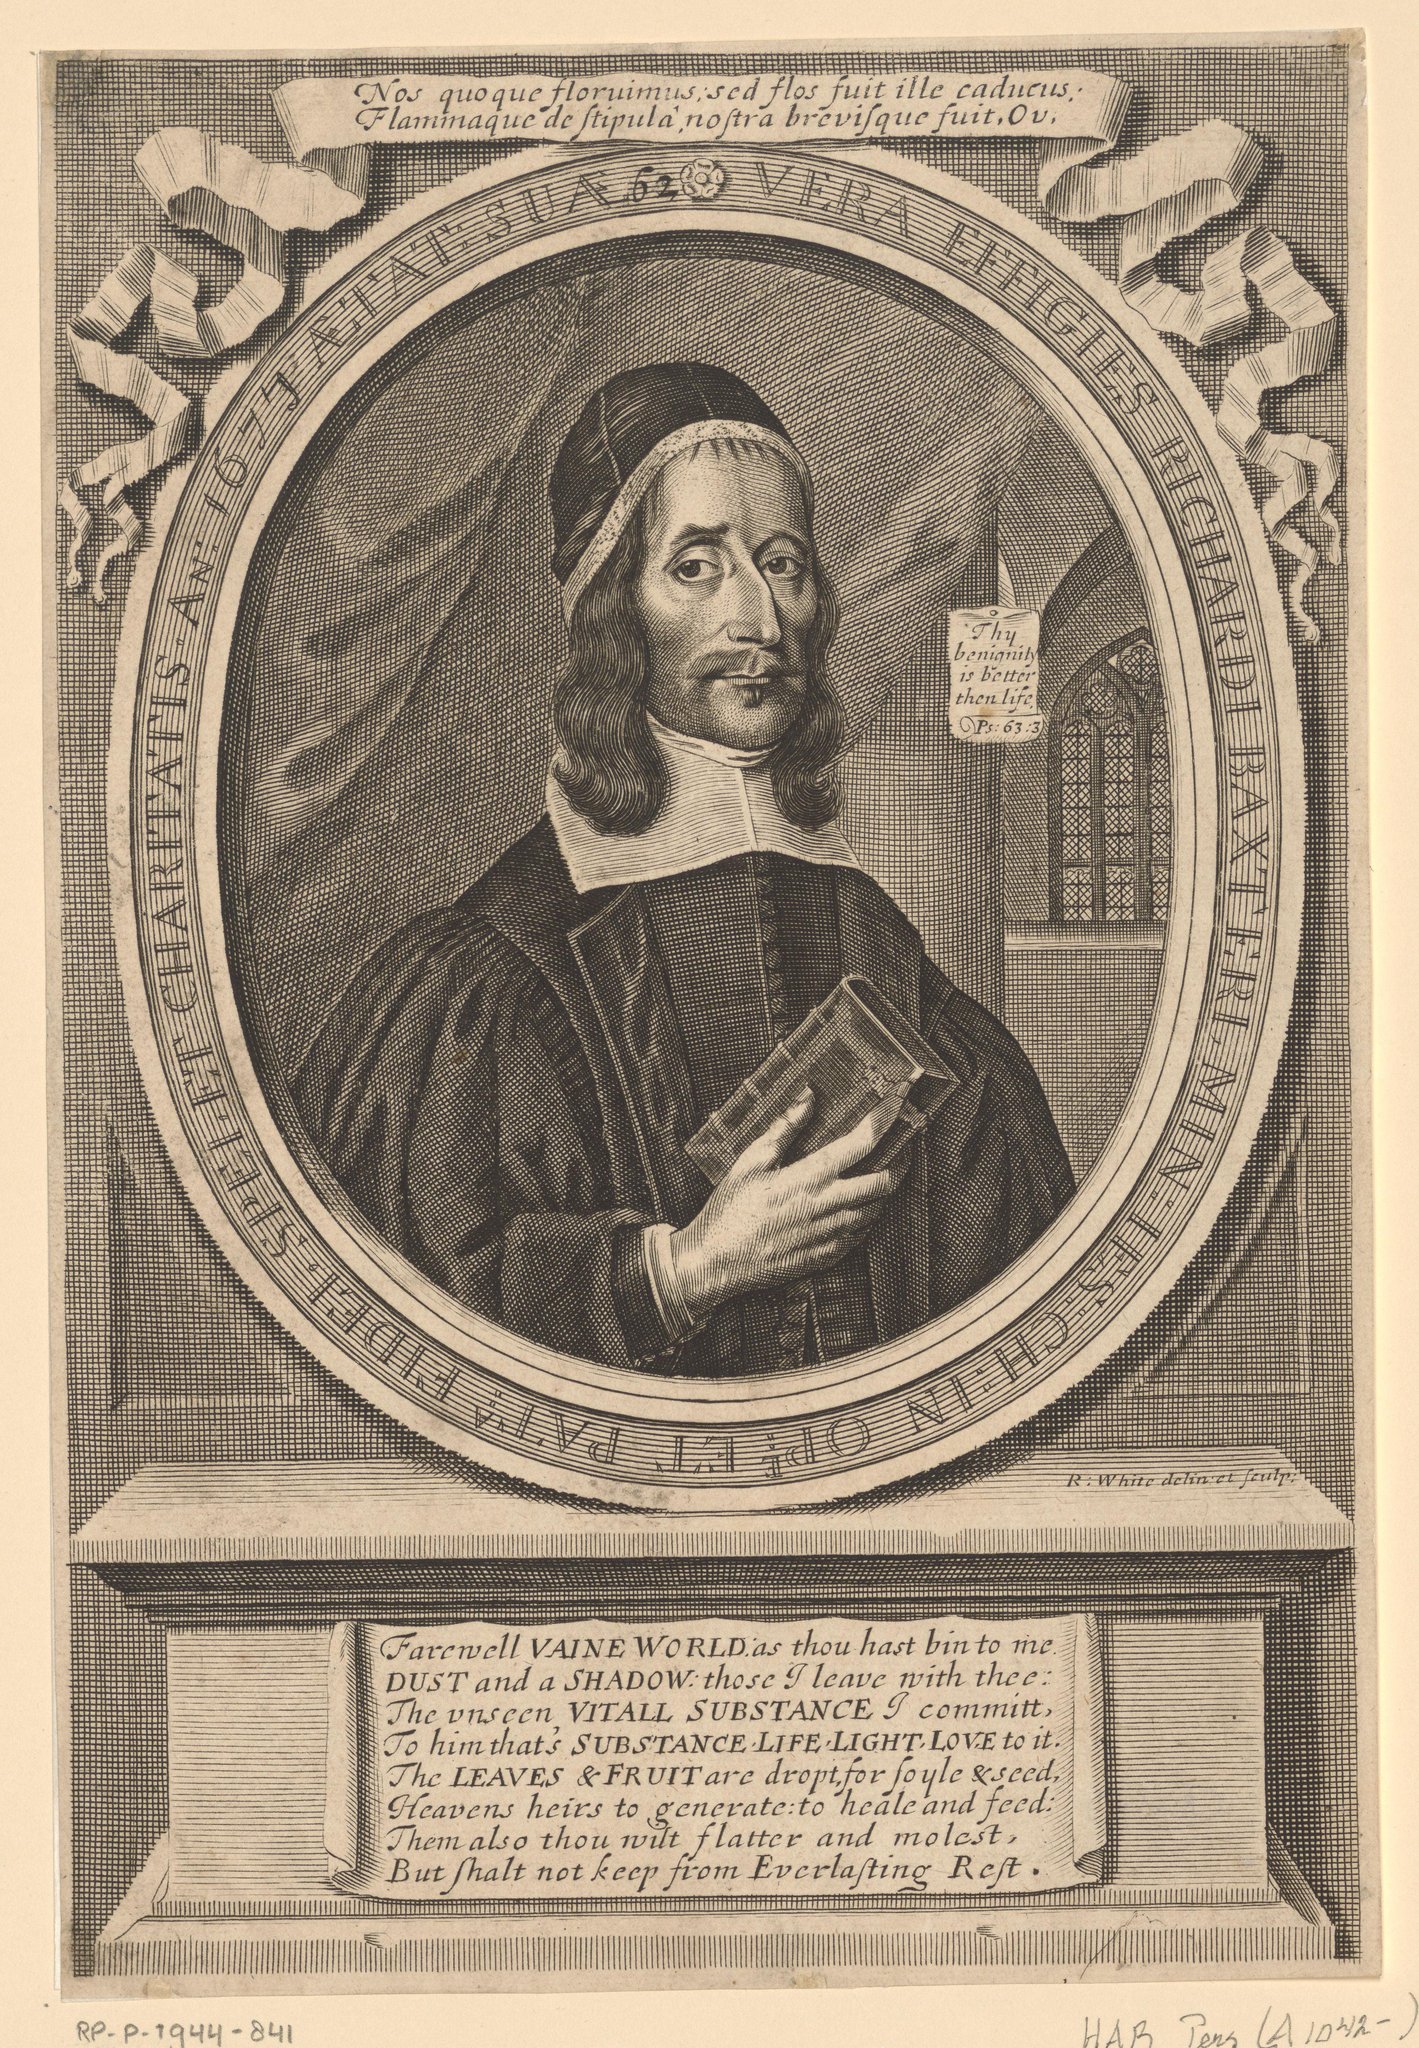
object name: print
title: Portret van Richard Baxter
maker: robert white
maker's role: print maker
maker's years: 1645-1703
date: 1677-1703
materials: paper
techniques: engraving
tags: london, historical persons, portrait, self-portrait of artist, writer, poet, author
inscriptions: collector's mark: Lugt 2228